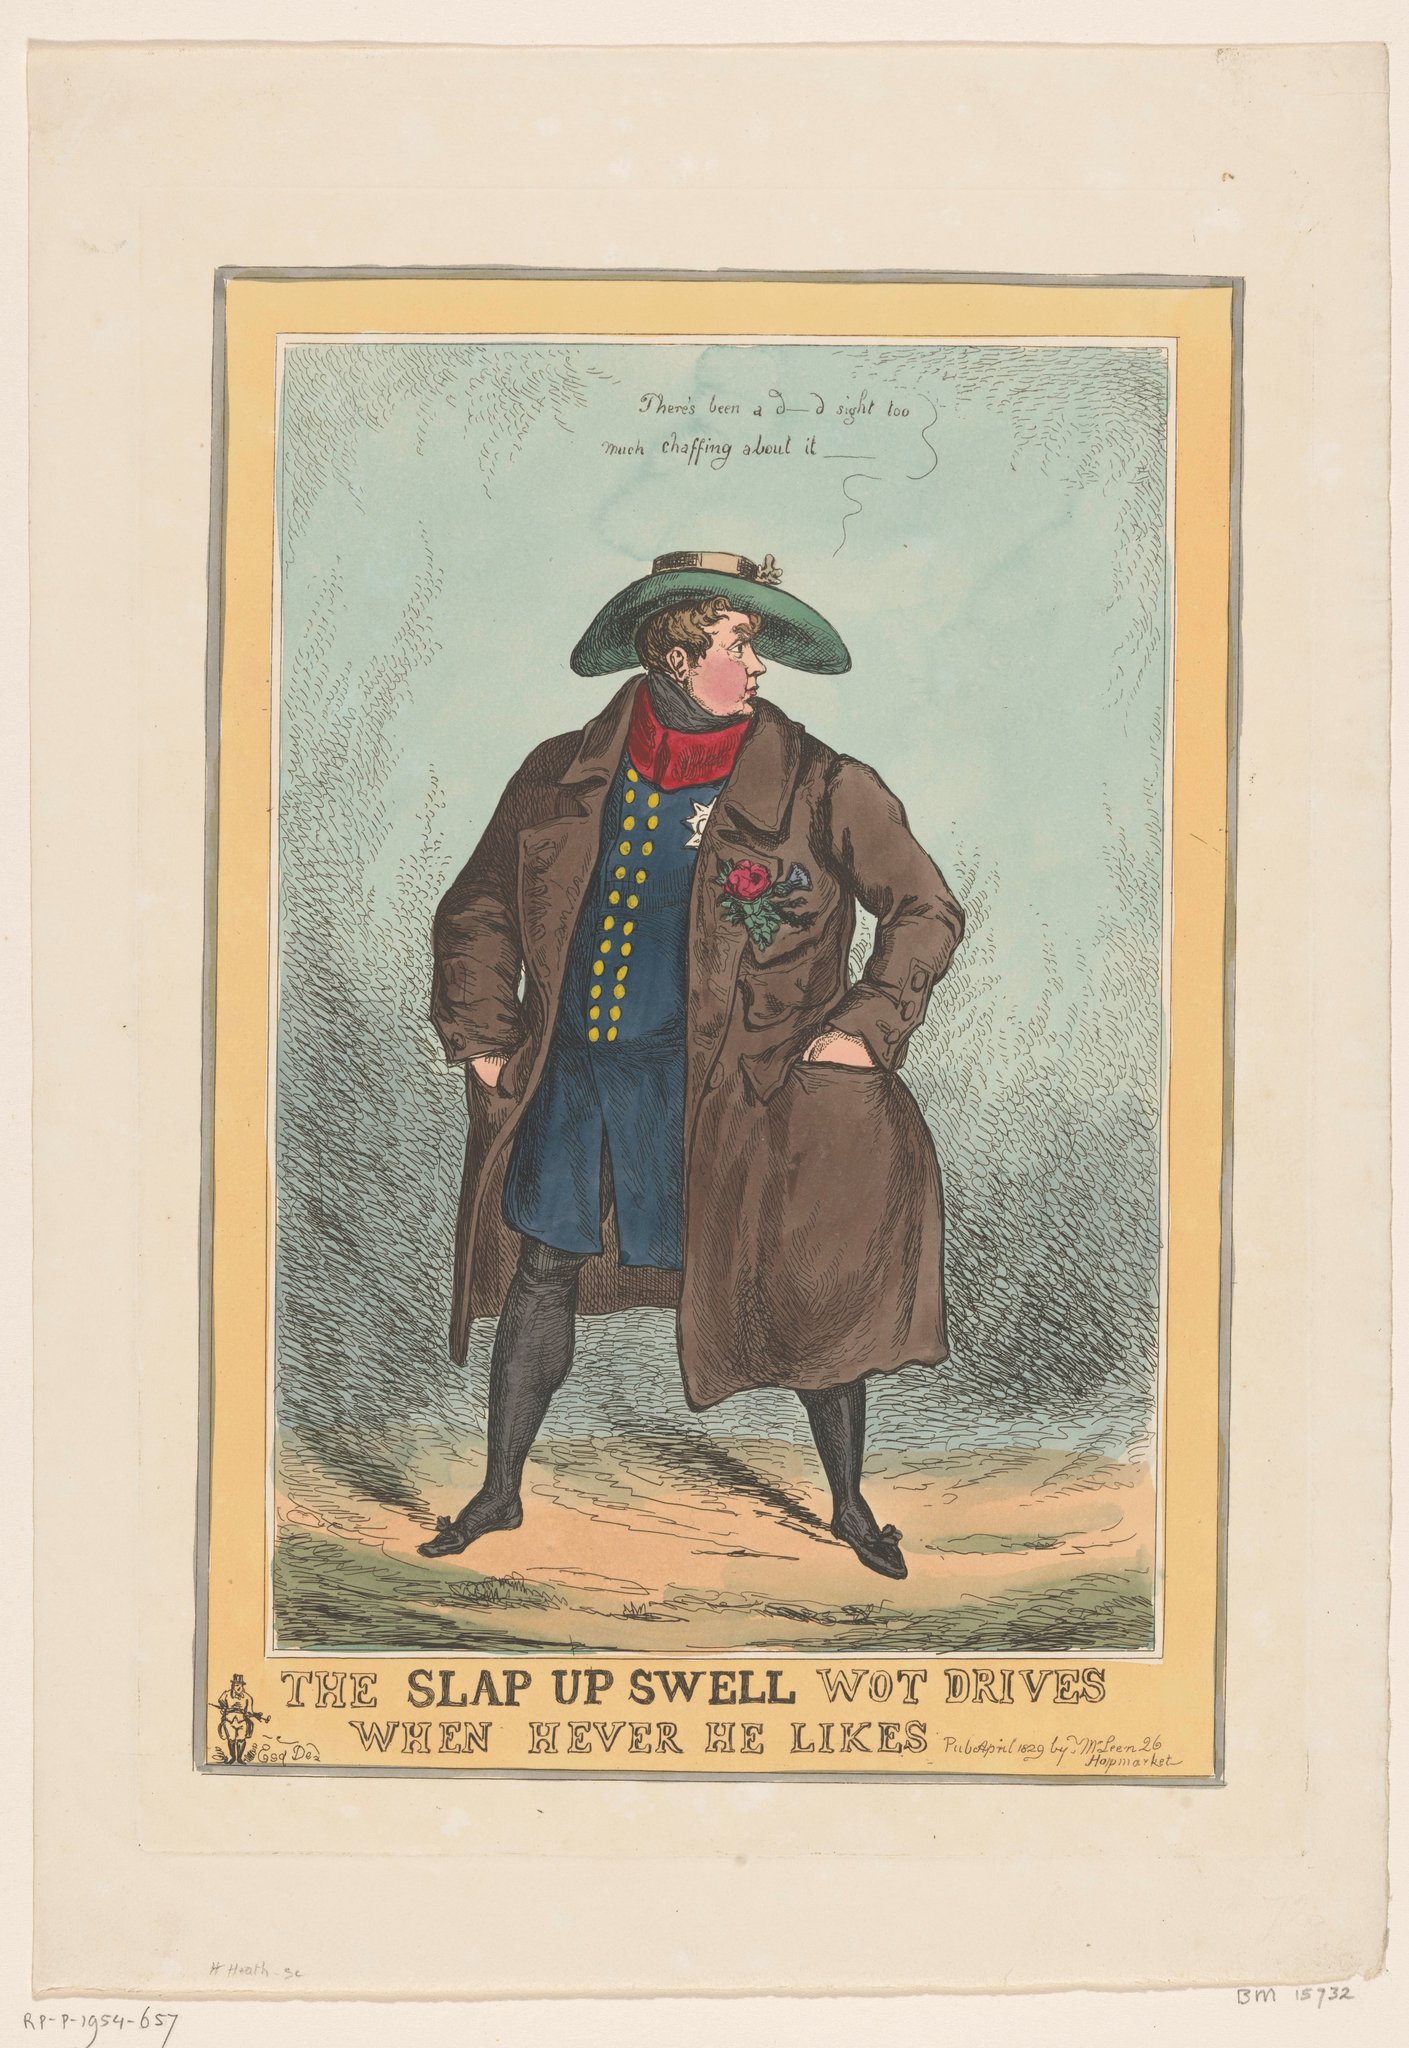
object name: print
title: Koning George IV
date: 1804-1829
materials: paper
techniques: etching, hand coloring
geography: england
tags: george iv (koning van het verenigd koninkrijk), dandy, beau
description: Spotprent met een voorstelling van koning George IV als een stoere modieuze figuur, staande met de benen uit elkaar, in een lange jas en een hoed met brede rand. Zie ook de pendant.